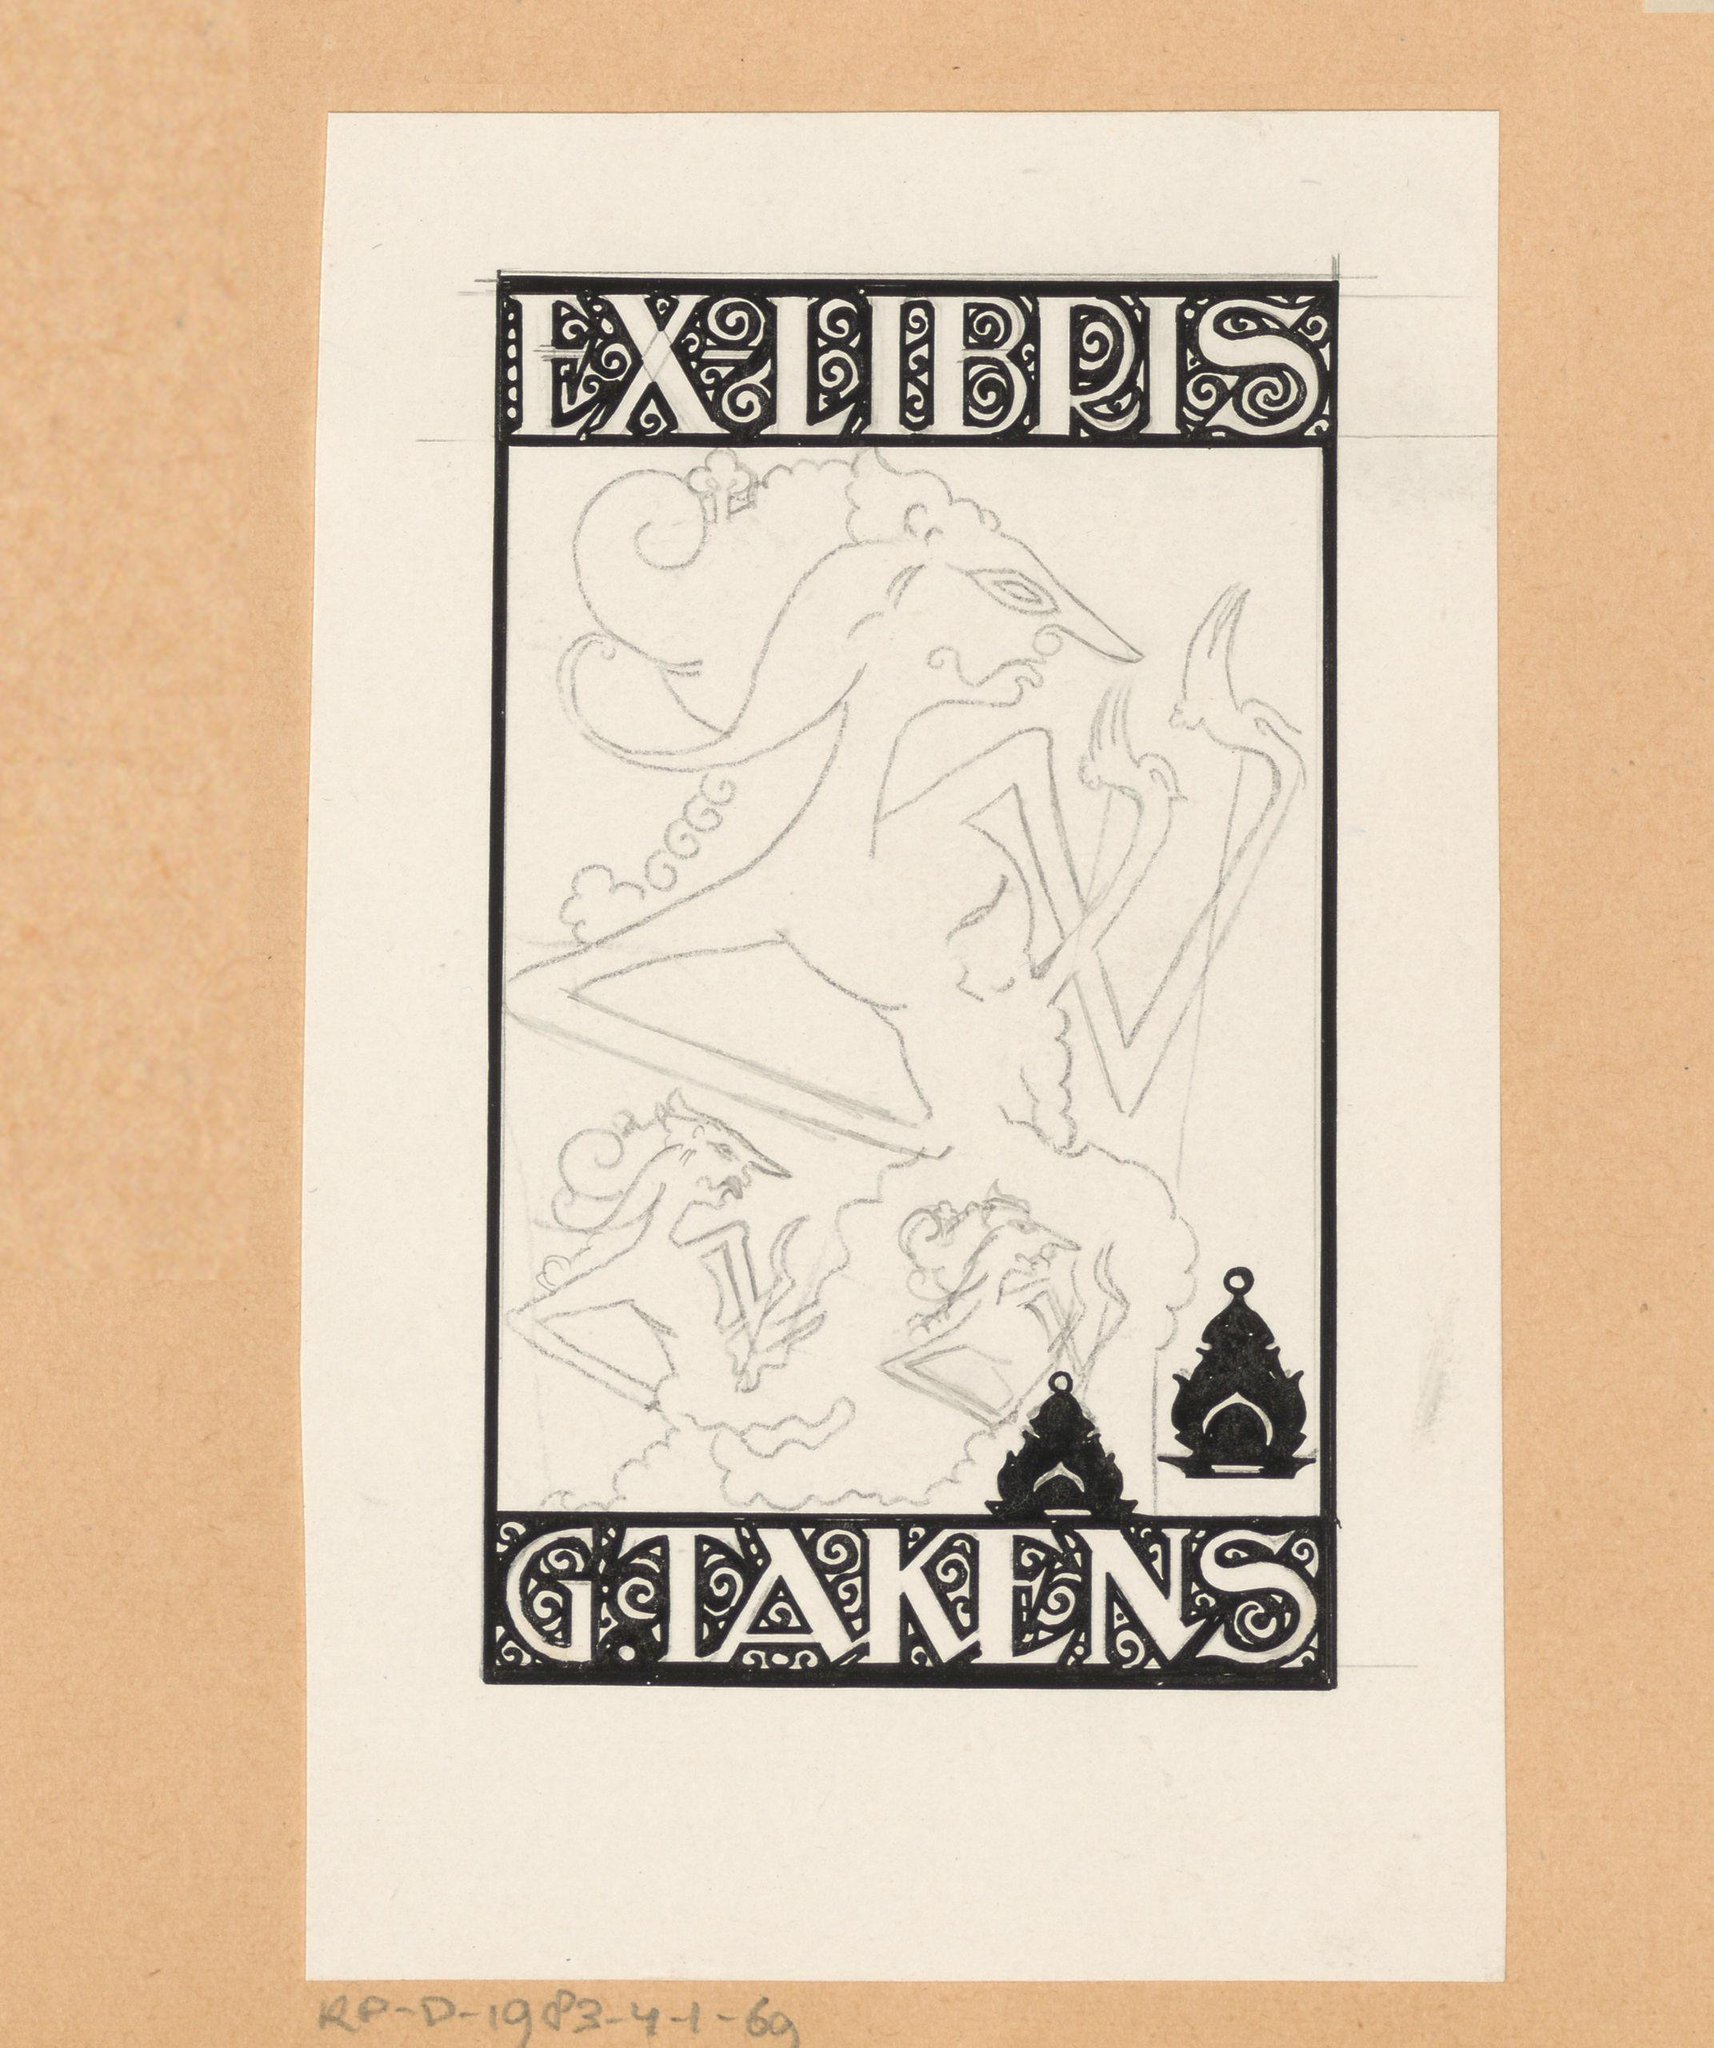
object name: bookplate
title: Ontwerptekening voor ex libris van G. Takens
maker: otto verhagen (i)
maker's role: draughtsman, print maker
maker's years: 1885-1951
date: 1932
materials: ink, paper, pencil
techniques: drawing, pen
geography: netherlands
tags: shadow-play, puppet and marionette show, indonesia